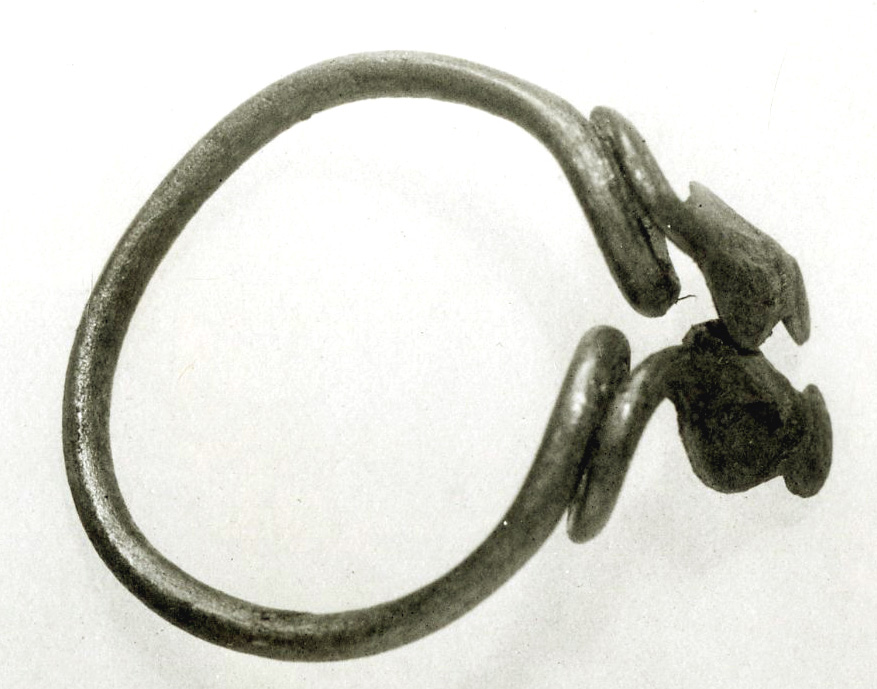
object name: bracelet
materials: silver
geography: egypt